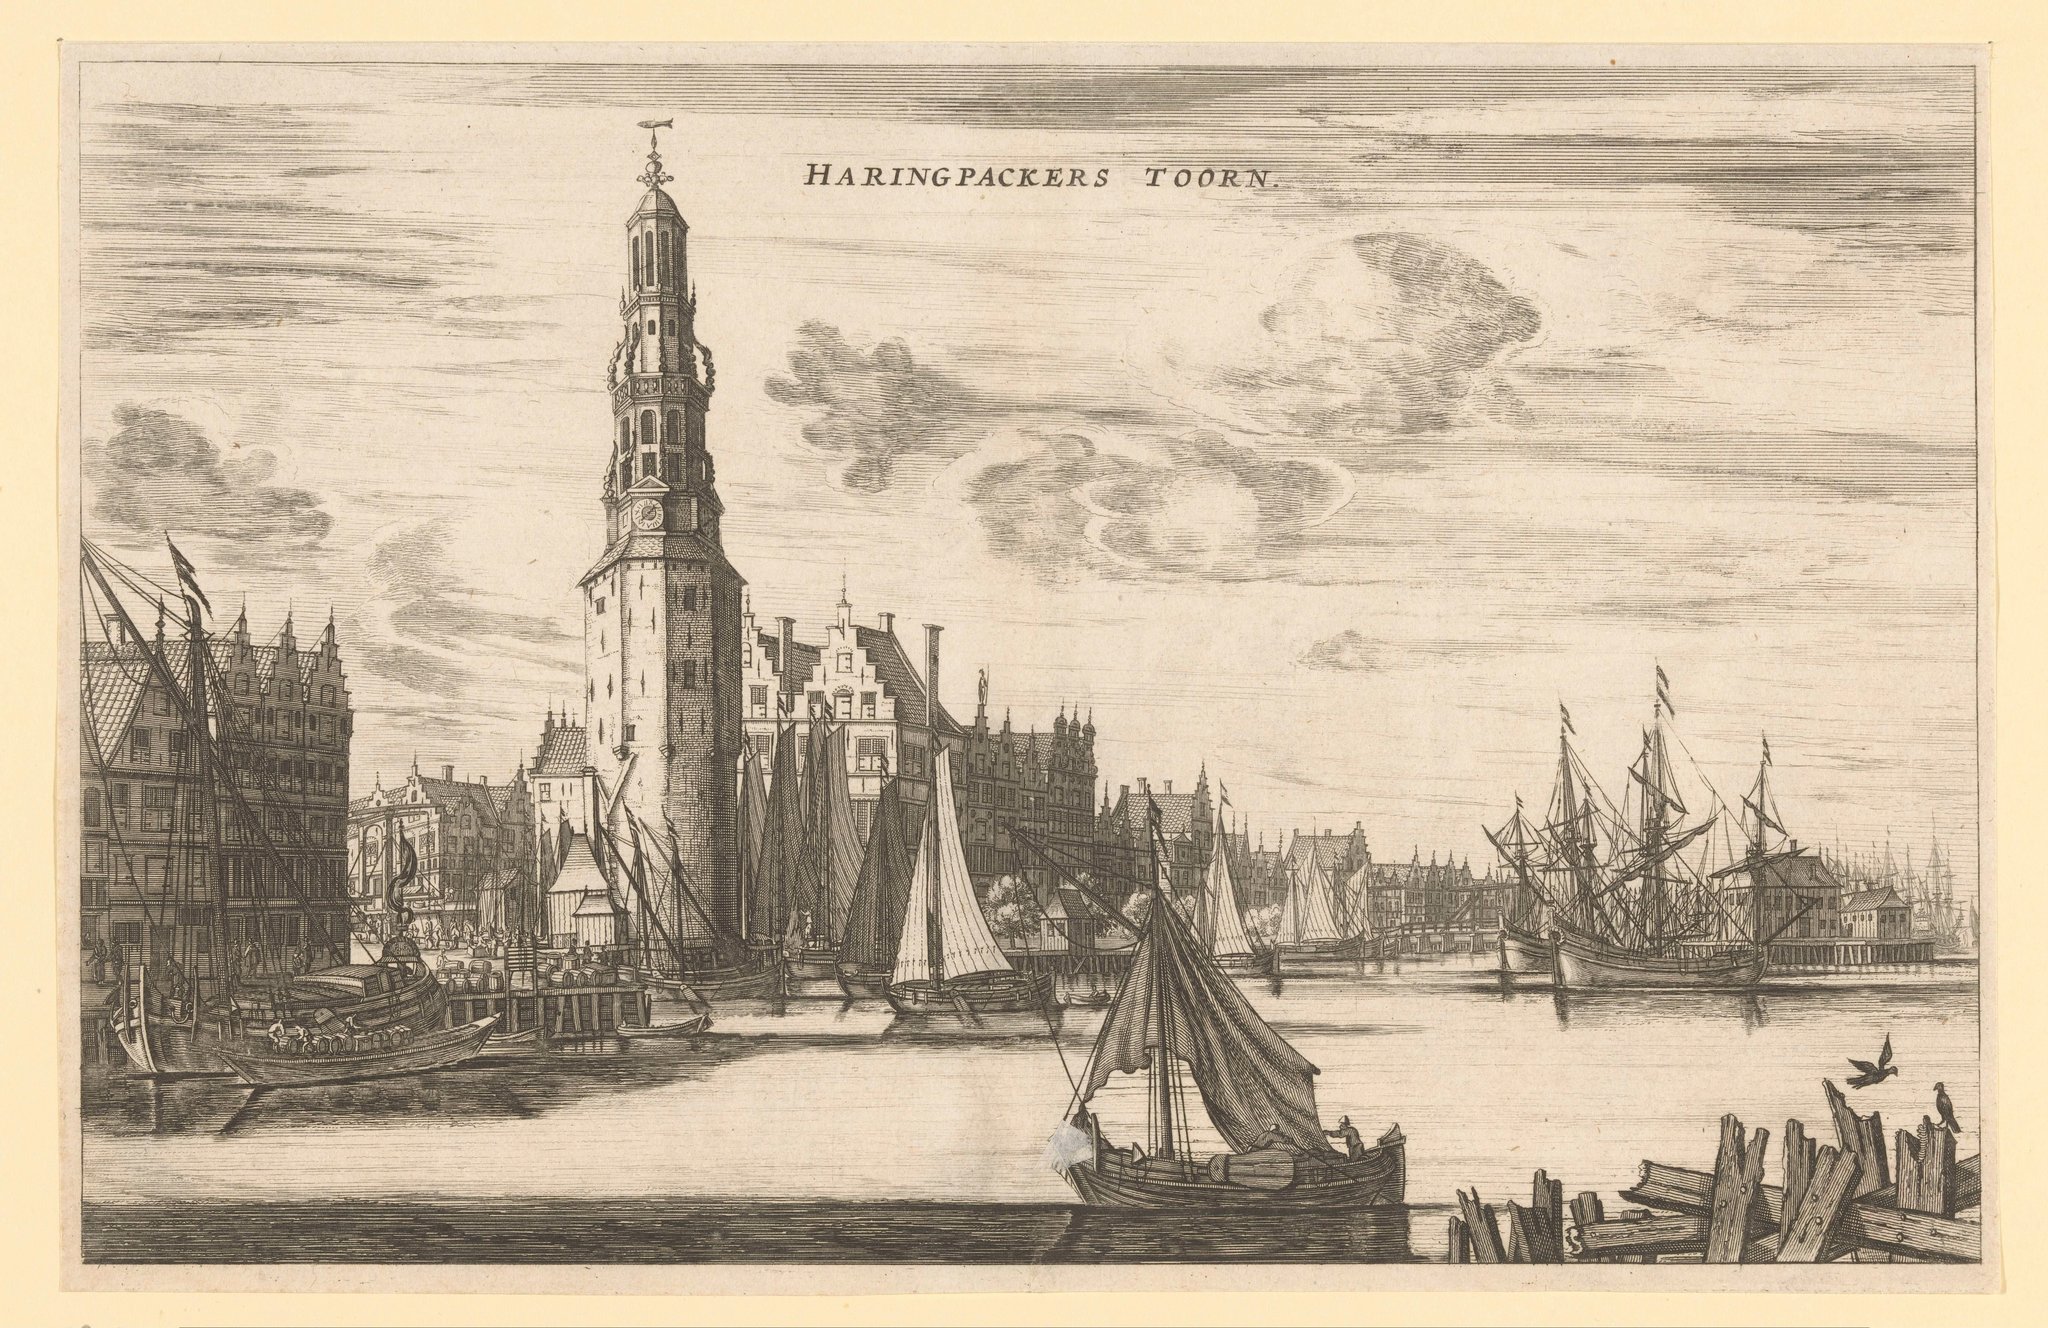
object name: book illustration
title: Gezicht op de Haringpakkerstoren te Amsterdam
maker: jacob van meurs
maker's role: draughtsman, print maker, publisher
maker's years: 1619-1680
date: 1663-1664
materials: paper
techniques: engraving, etching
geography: amsterdam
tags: tower, clock tower ~ monumental adornment, towers ~ fortified city, canals, waters (in city) (+ city(-scape) with figures, staffage), street (+ city(-scape) with figures, staffage)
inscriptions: collector's mark: Lugt 195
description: Huidige staat van prent ook gebruikt in: Dapper, Olfert. Historische beschryving der stadt Amsterdam: waer in de voornaemste geschiedenissen (na een kort verhael van gansch Hollant en d'omleggende dorpen (…). Amsterdam: Jacob van Meurs, 1663.* En in: Zesen, Philipp von. Beschreibung der Stadt Amsterdam: darinnen von derselben ersten Ursprunge bis auf gegenwärtigen Zustand (…). Amsterdam: Joachim Nosche, 1664. * In sommige exemplaren van deze uitgave komt de huidige staat van de prent voor. In andere exemplaren is een latere staat ingebonden, waarop boven de Nederlandse een Franse titel is toegevoegd.